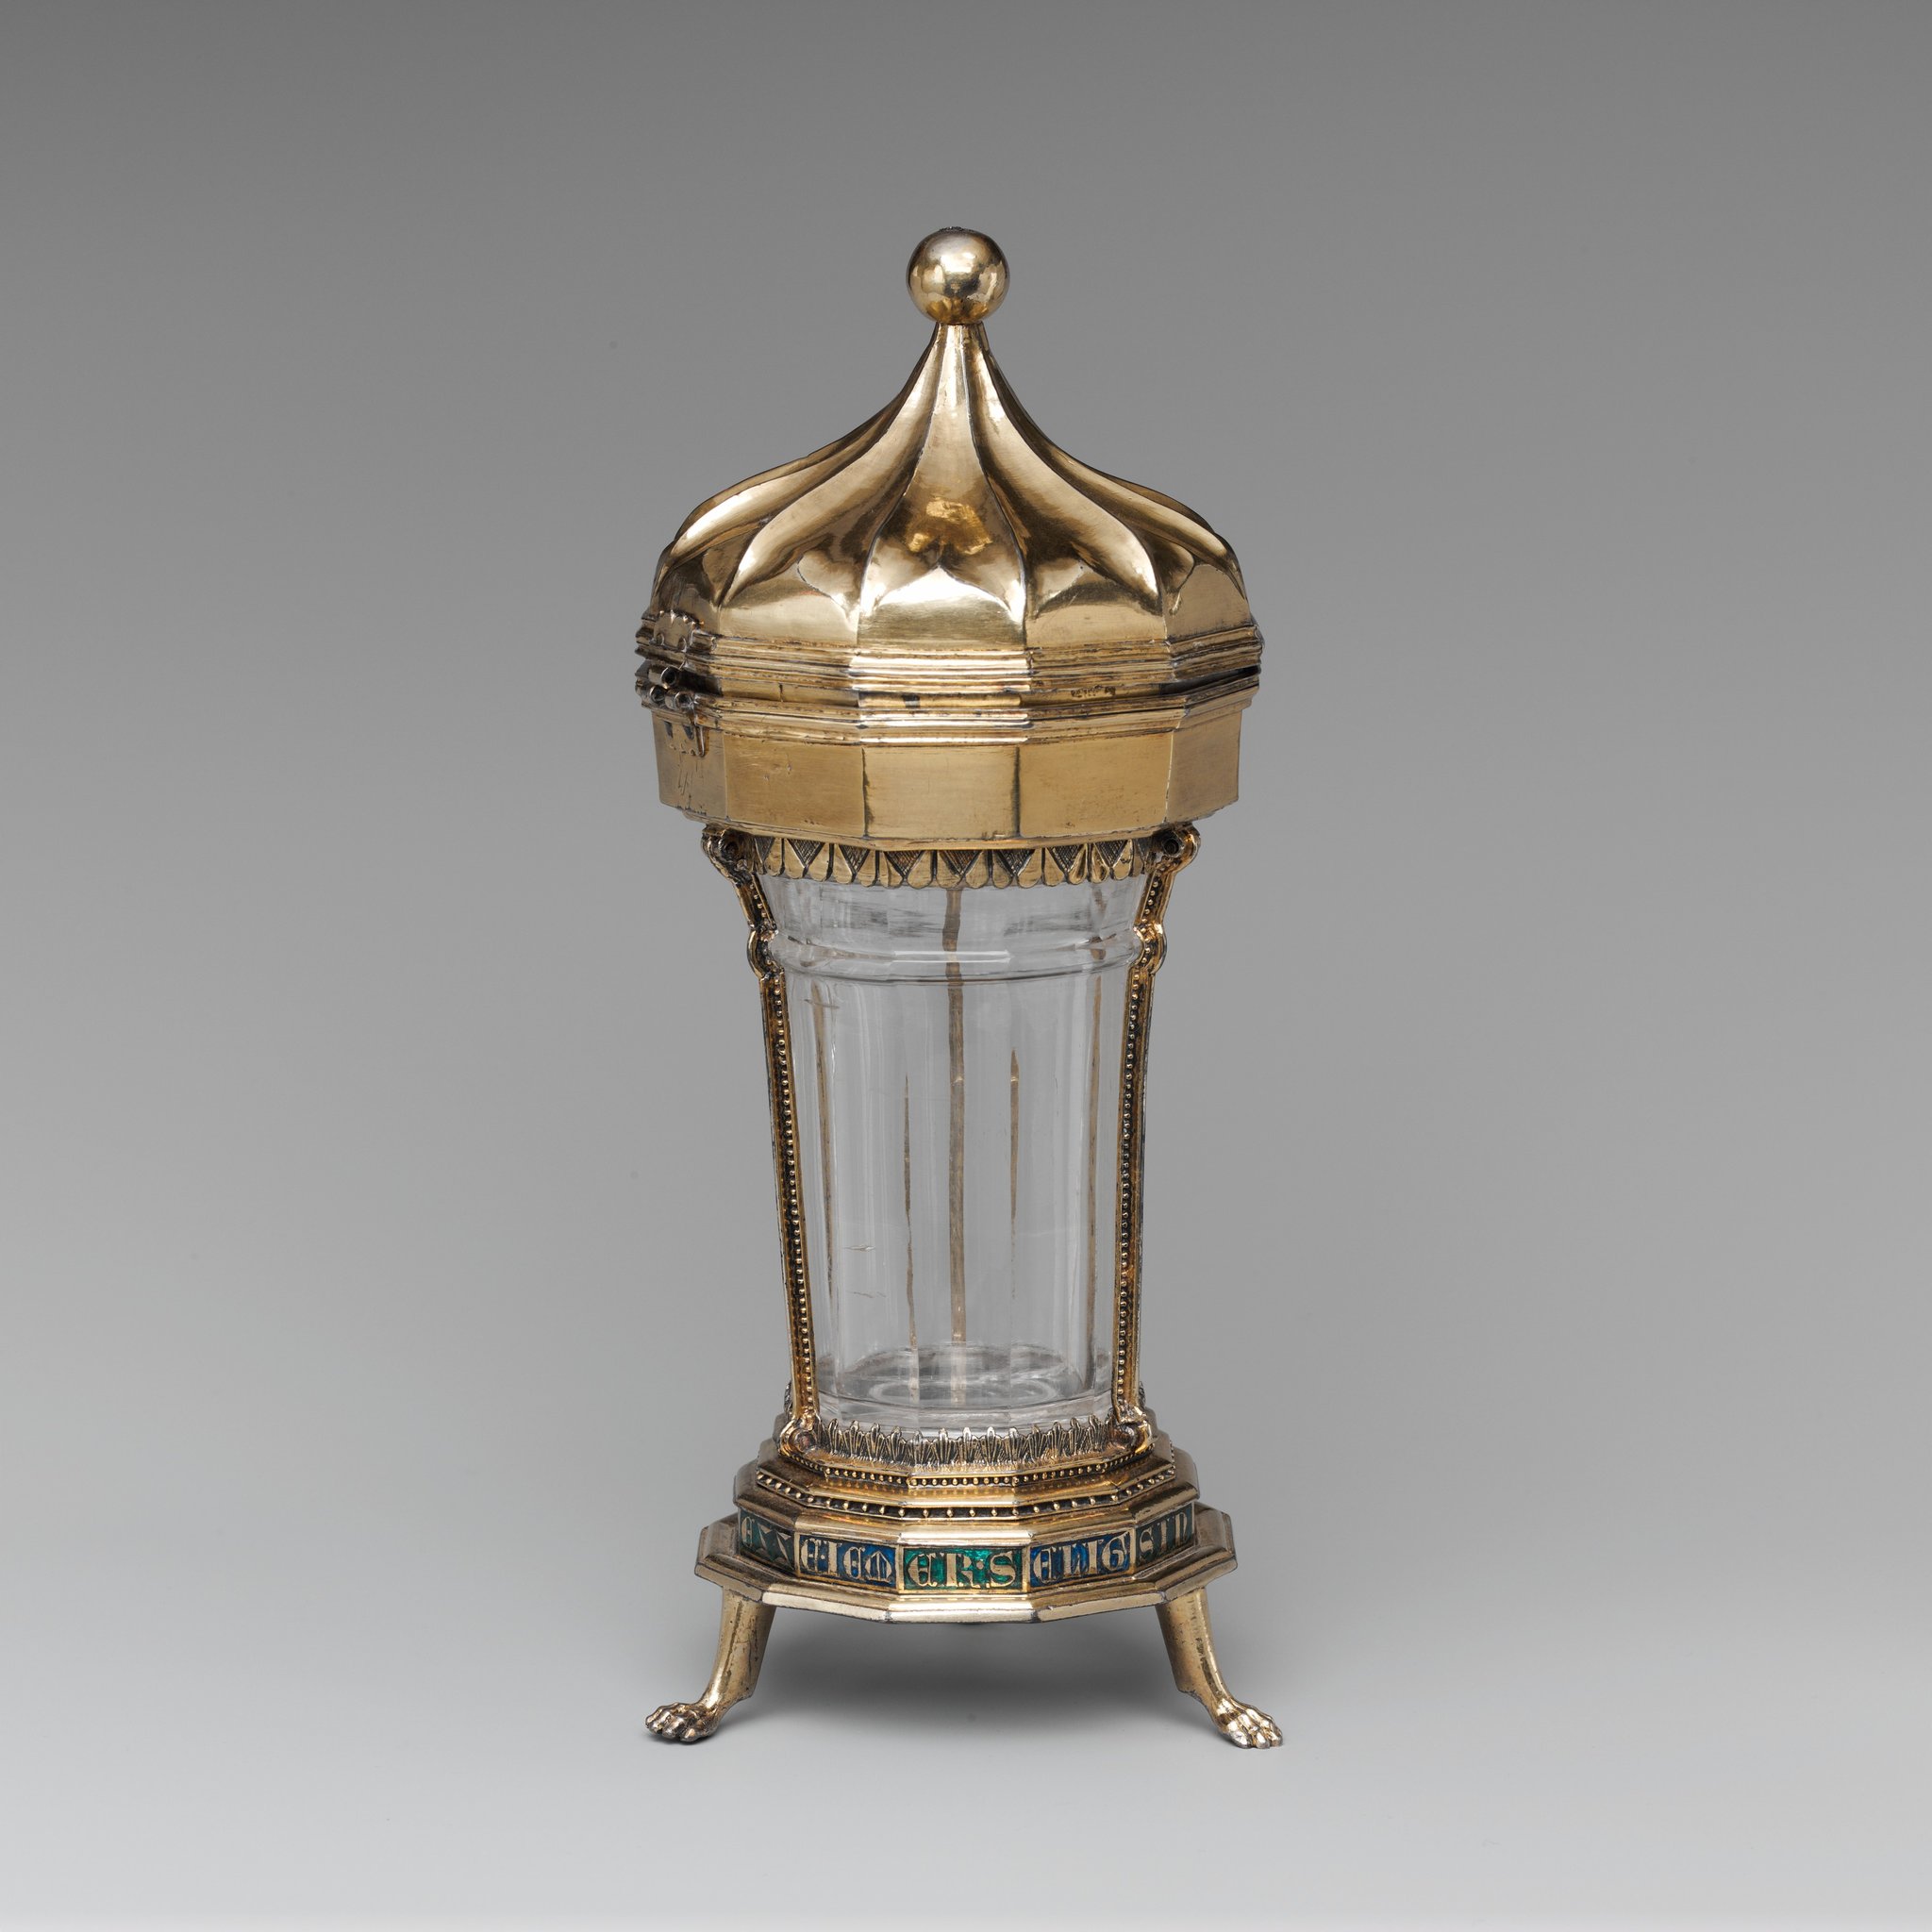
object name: beaker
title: Covered Beaker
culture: italian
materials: enamel, quartz, silver gilt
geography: austria